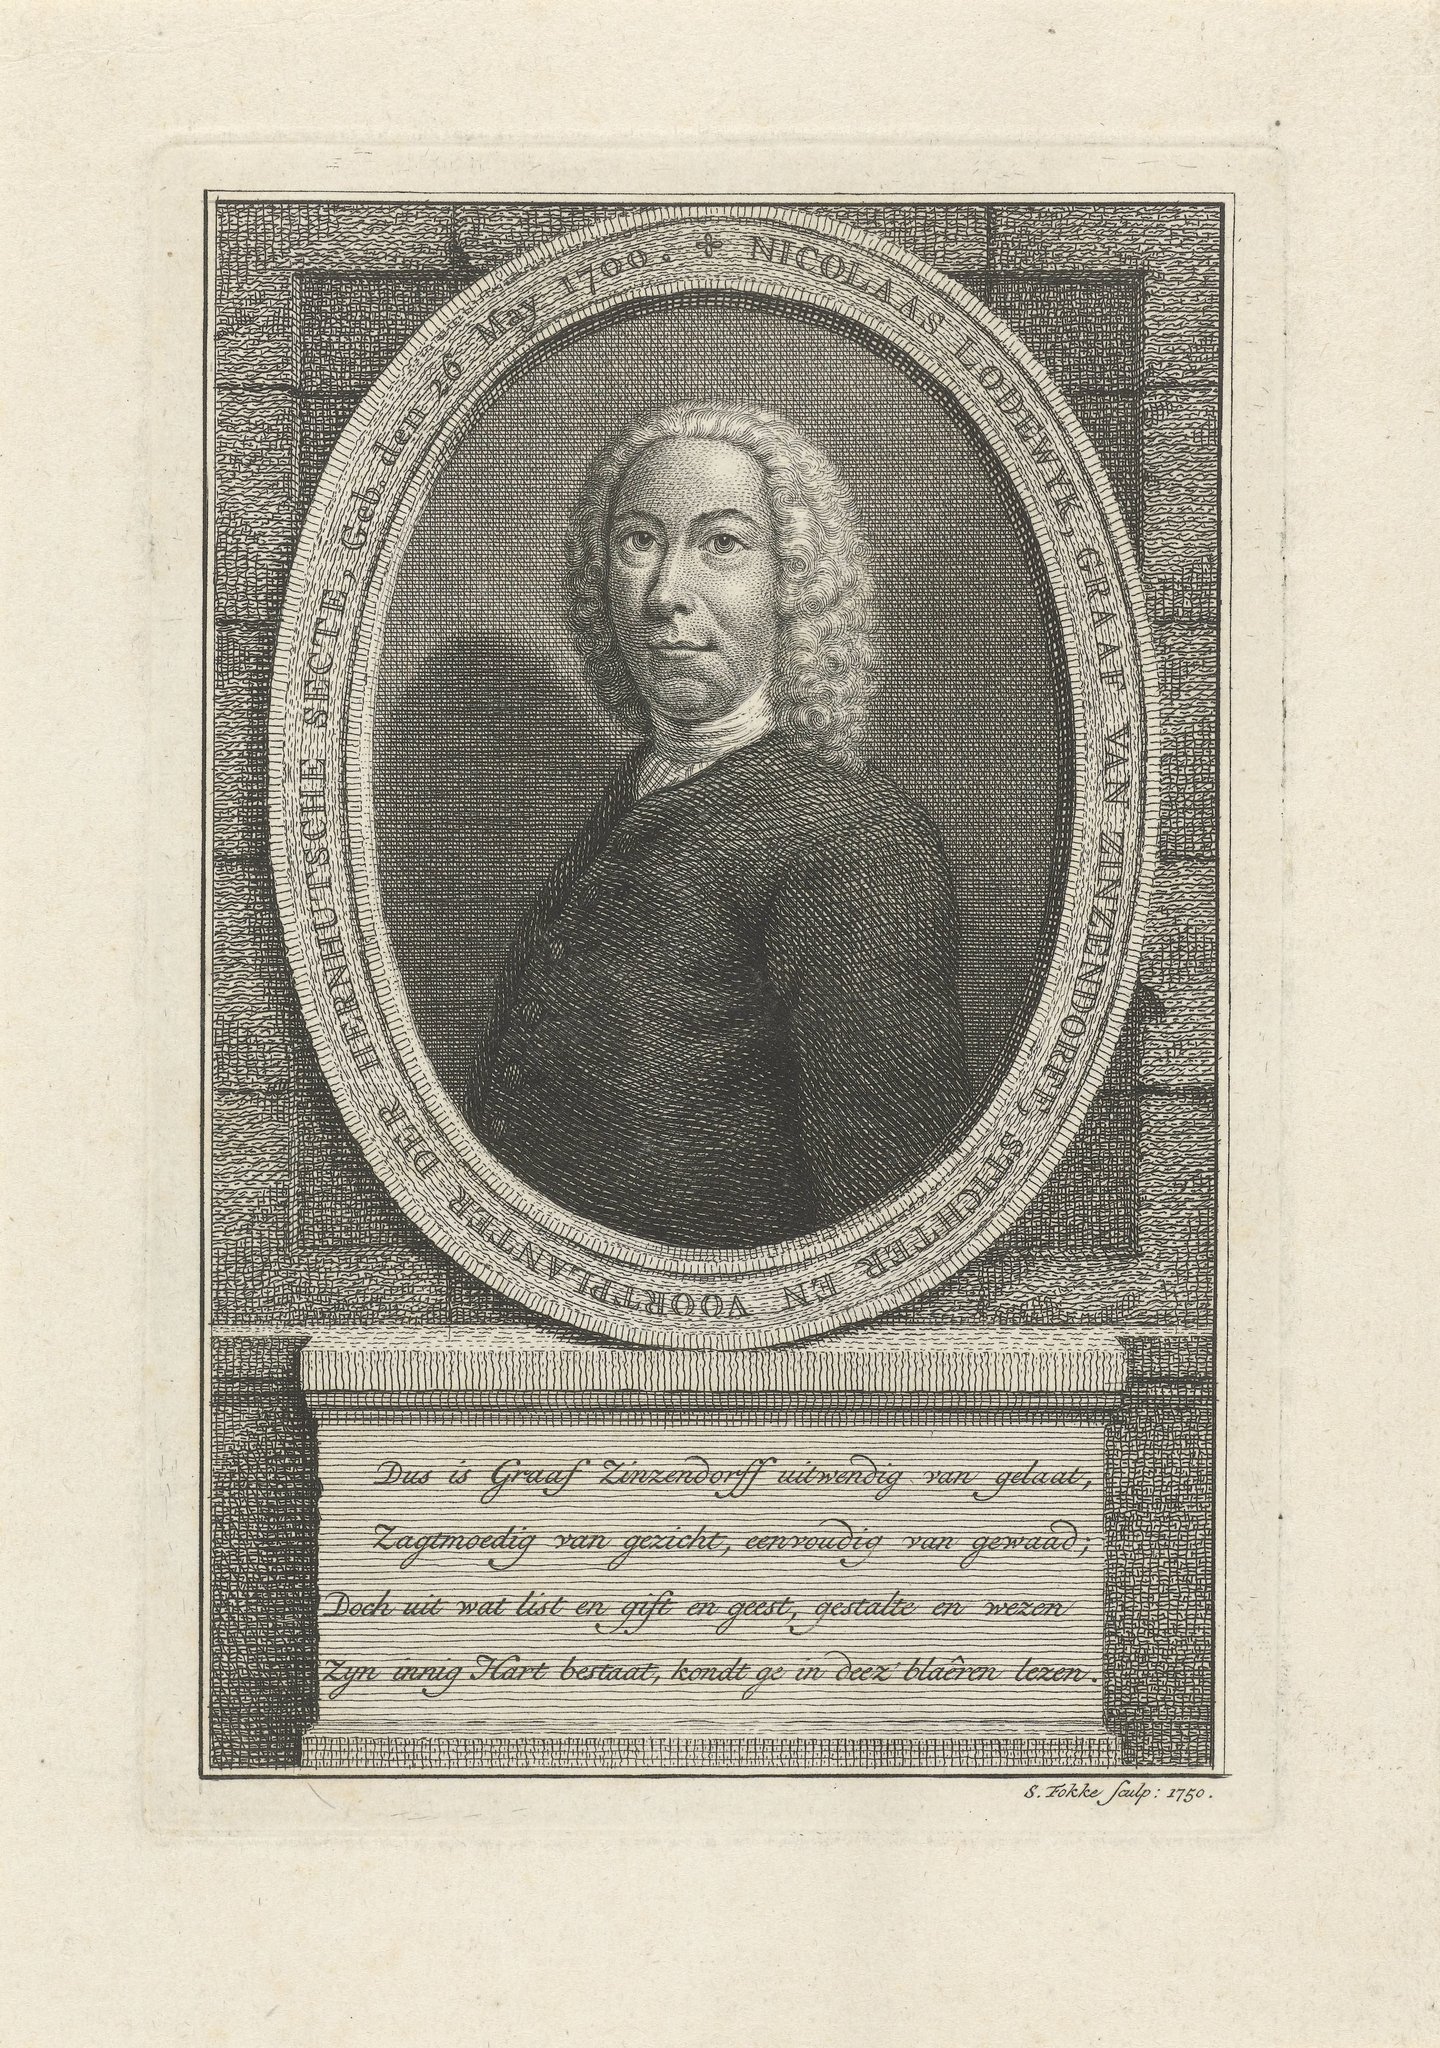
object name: print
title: Portret van Nicolaas Lodewijk, Graaf van Zinzendorff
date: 1750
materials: paper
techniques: etching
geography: amsterdam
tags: historical person (with name)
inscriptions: collector's mark: Lugt 2228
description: Portretbuste in ovaal van Nicolaas Lodewijk, Graaf van Zinzendorff, naar links. Om het portret staat een randschrift en onder het portret vier regels tekst, beide in het Nederlands.